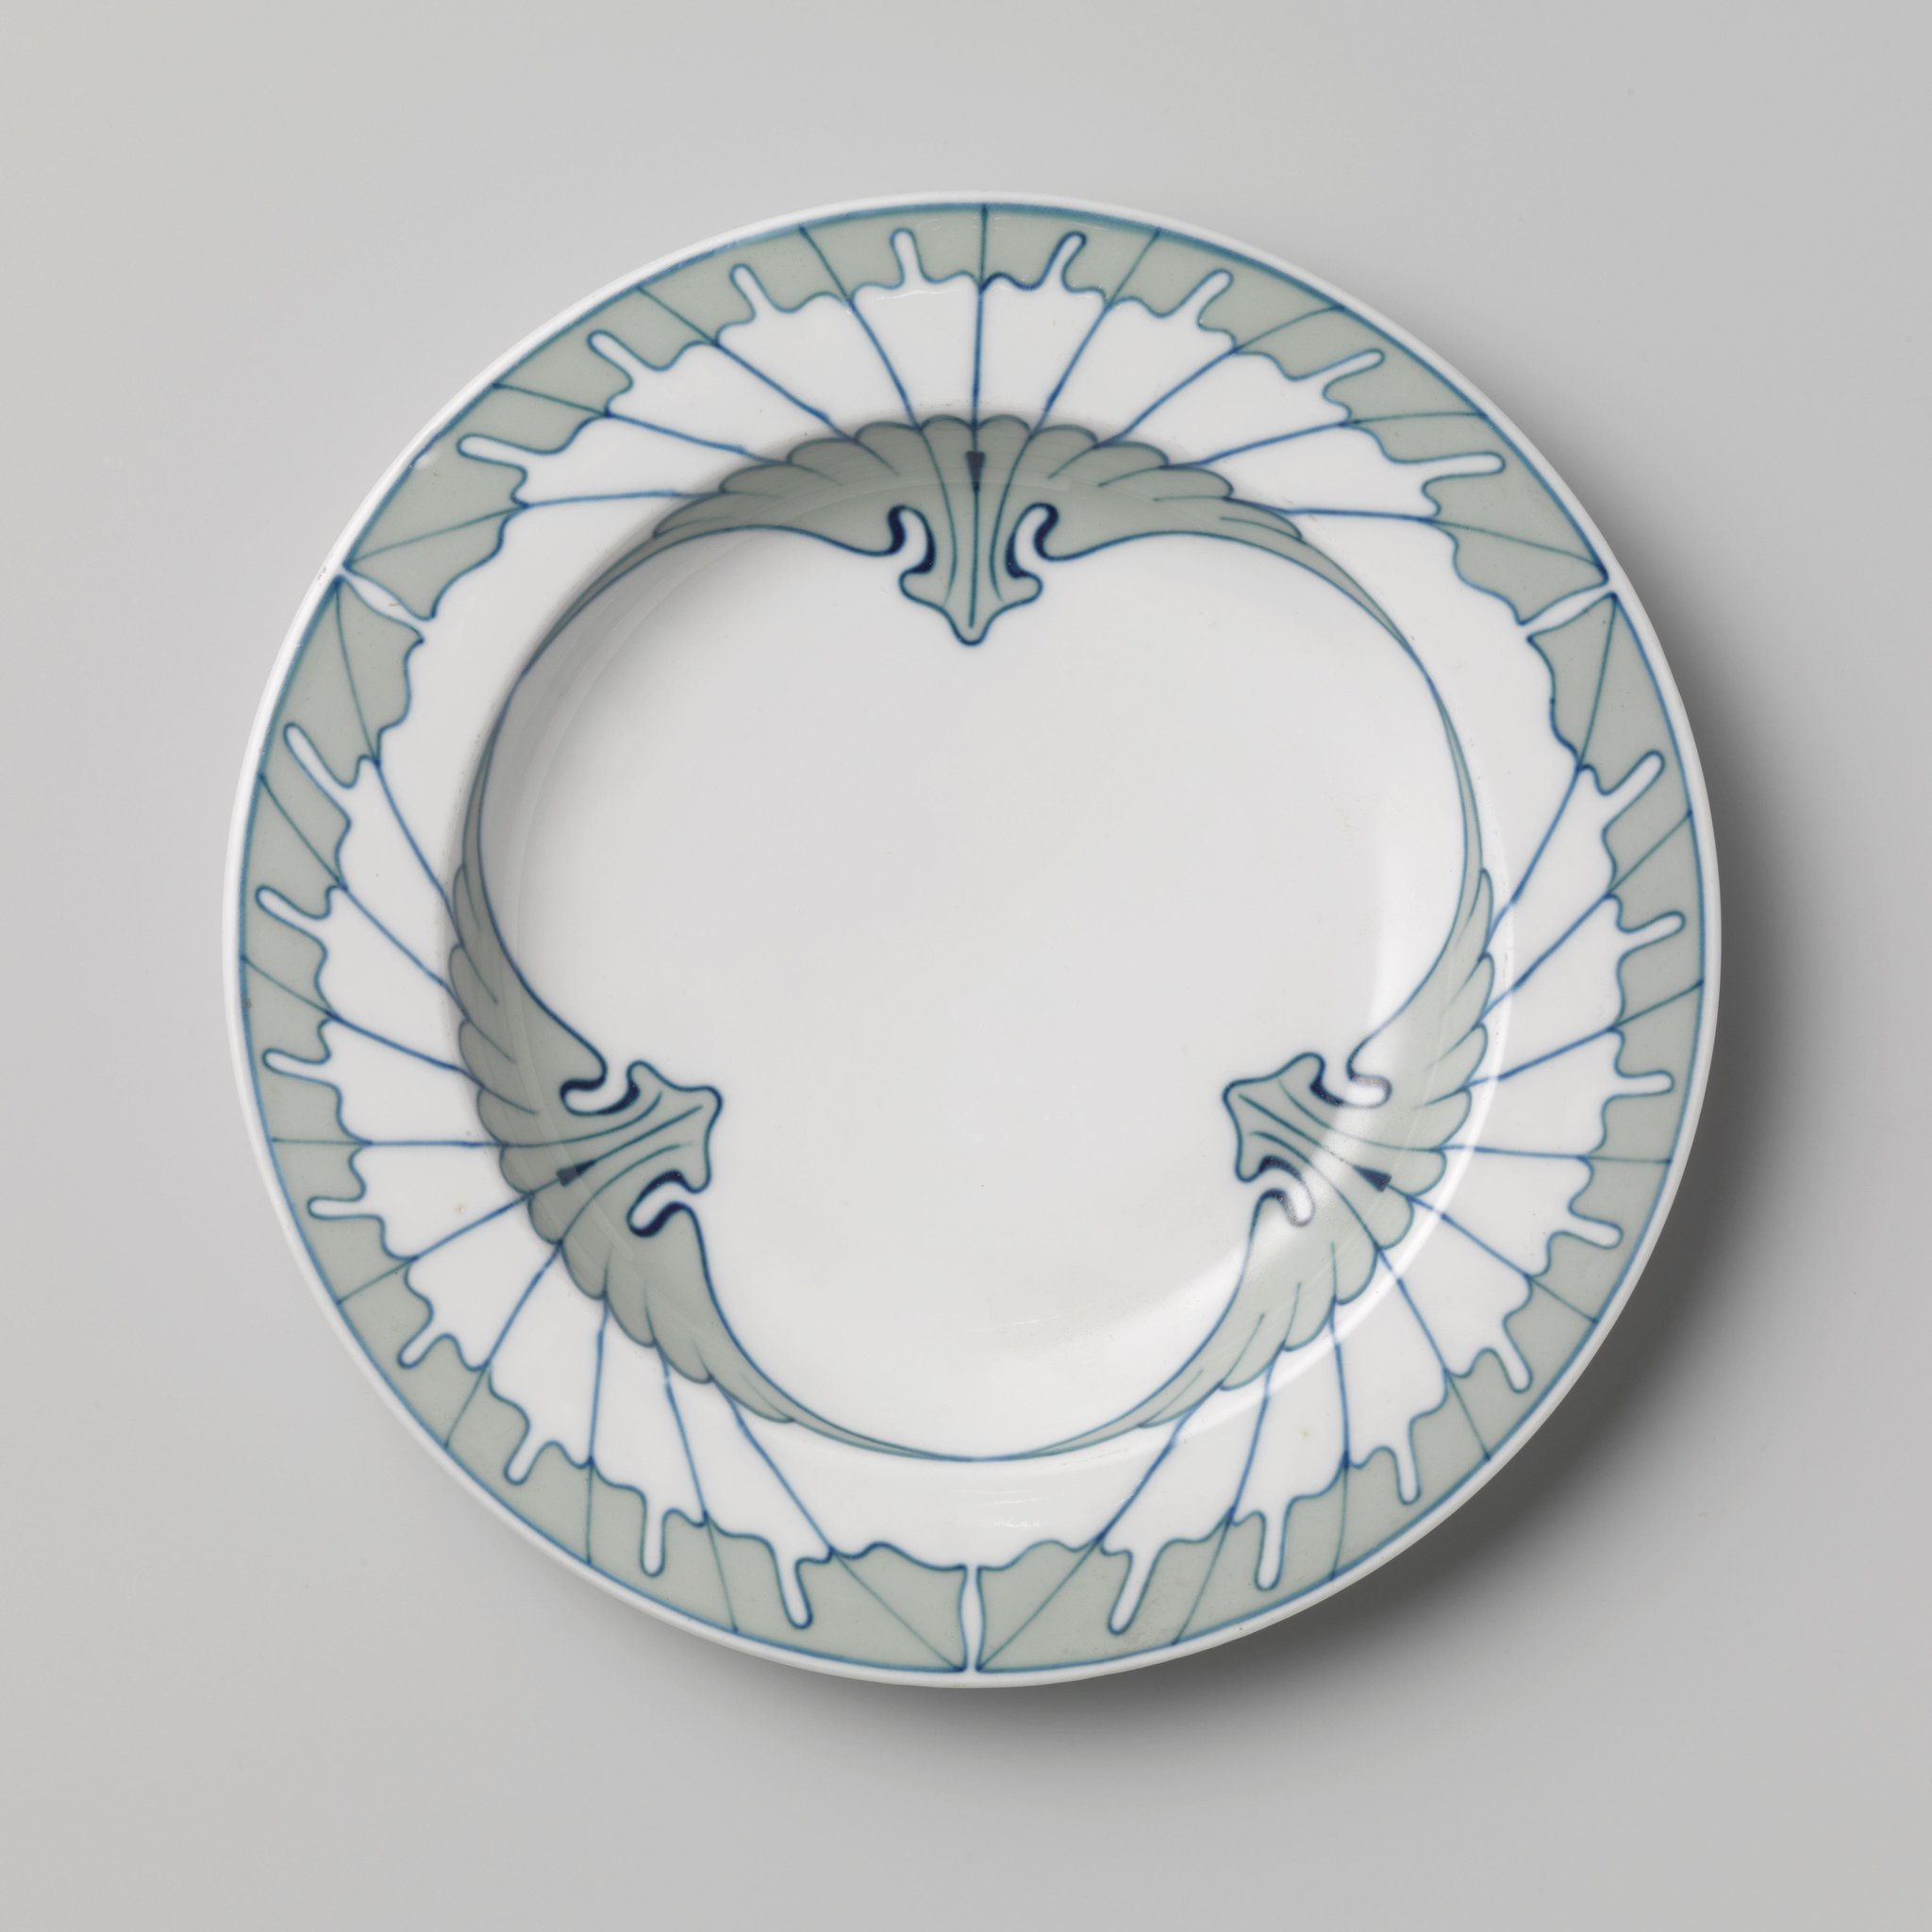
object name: soup plate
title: Soepbord, beschilderd met het Flügelmuster-decor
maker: konrad hentschel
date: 1901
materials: porcelain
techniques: painted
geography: meissen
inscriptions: factory mark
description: Bord van beschilderd porselein. Het bord is beschilderd in groen en blauw met het Flügelmuster. Het bord hoort bij een servies (BK-1976-65-1 t/m BK-1976-65-34) en is gemerkt.